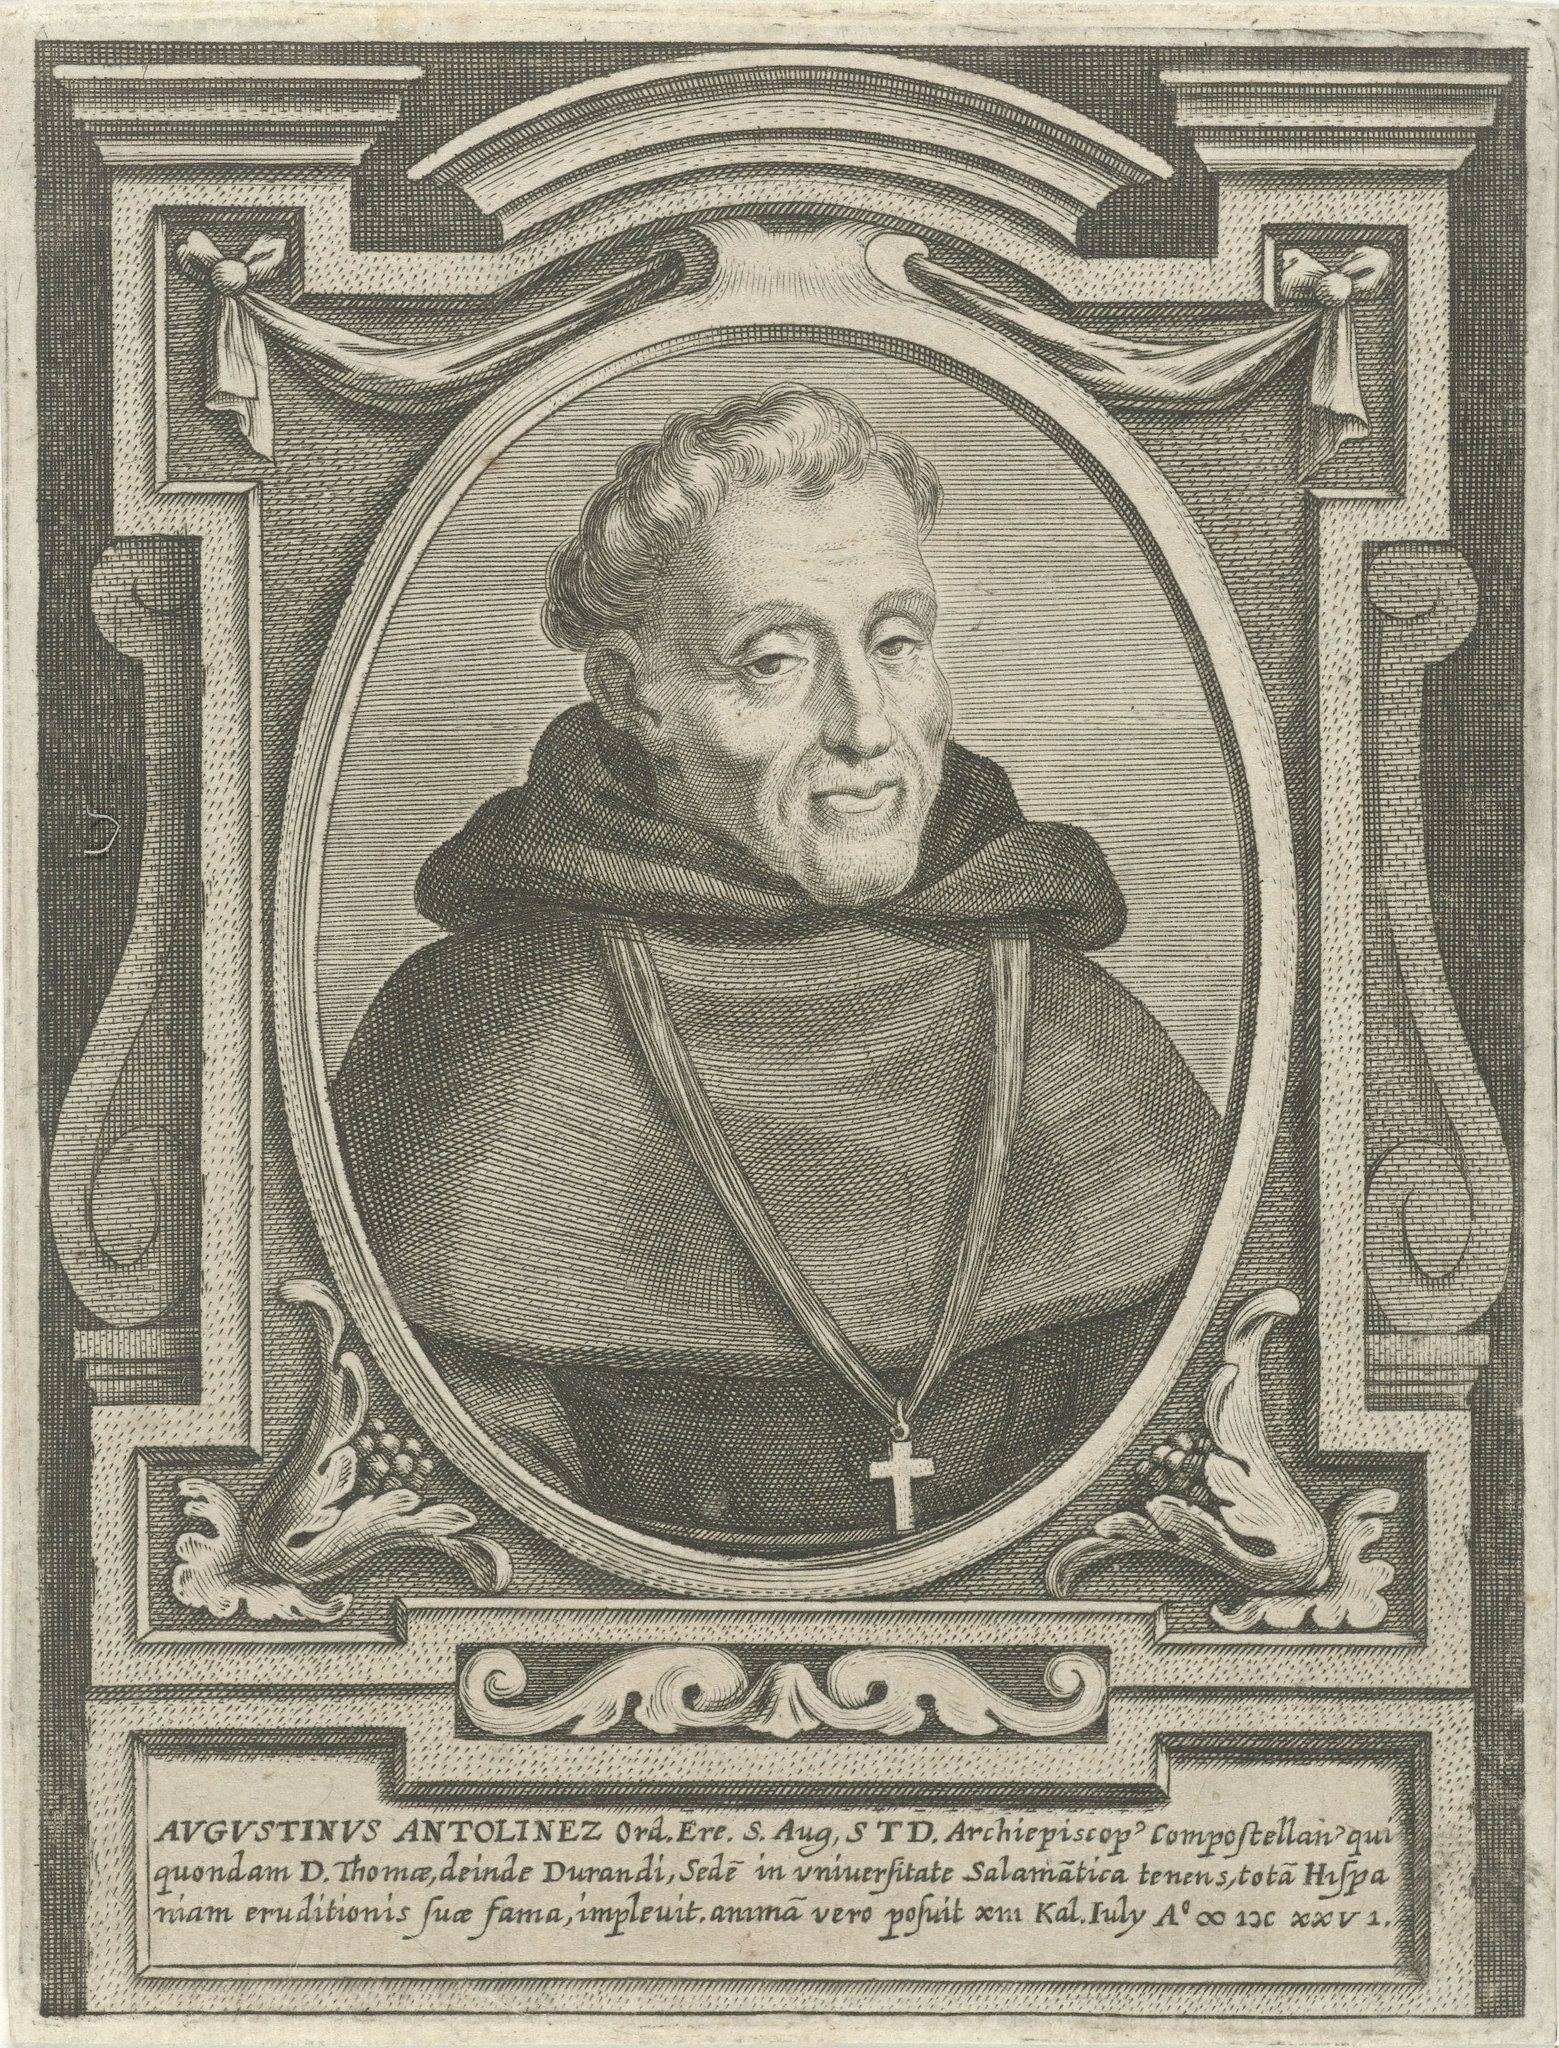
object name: print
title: Portret van de Augustijn Agustín Antolínez aartsbisschop van Santiago de Compostela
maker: cornelis galle (i)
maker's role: print maker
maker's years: 1576-1650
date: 1636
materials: paper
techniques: engraving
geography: southern netherlands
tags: monastic orders, monastic life ~ roman catholic church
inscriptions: collector's mark: Lugt 2228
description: Boekillustratie voor: C. Curtius, Virorum illustrium ex ordine Eremitarum D. Augustini elogia , Antwerpen: J. Cnobbaert, 1636.